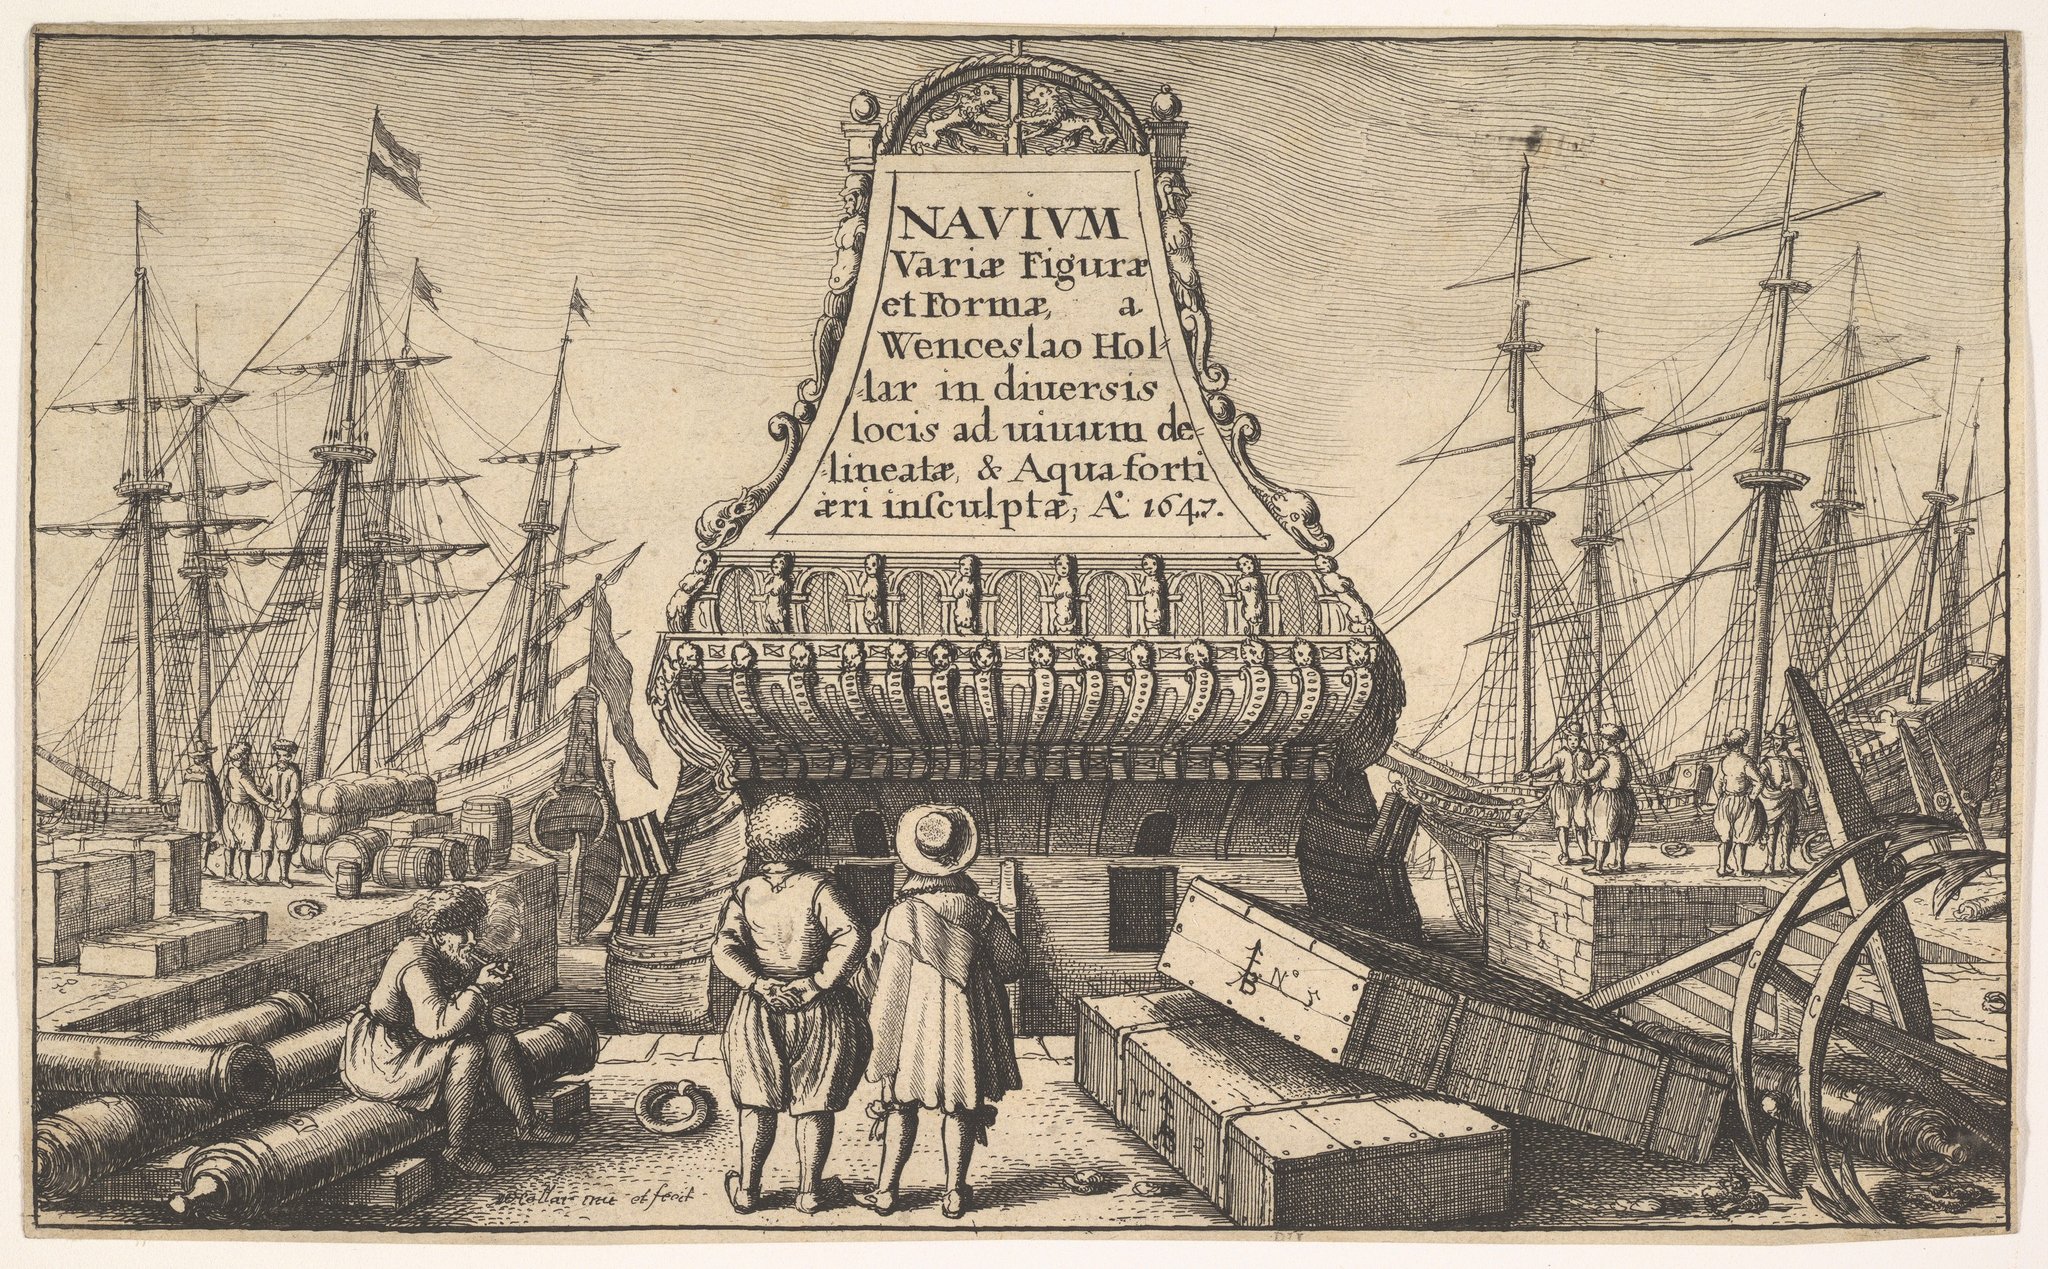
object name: print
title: Title page: Dutch Ships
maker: wenceslaus hollar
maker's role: artist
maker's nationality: bohemian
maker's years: 1607-1677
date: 1647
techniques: etching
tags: cannons,men,smoking,ships